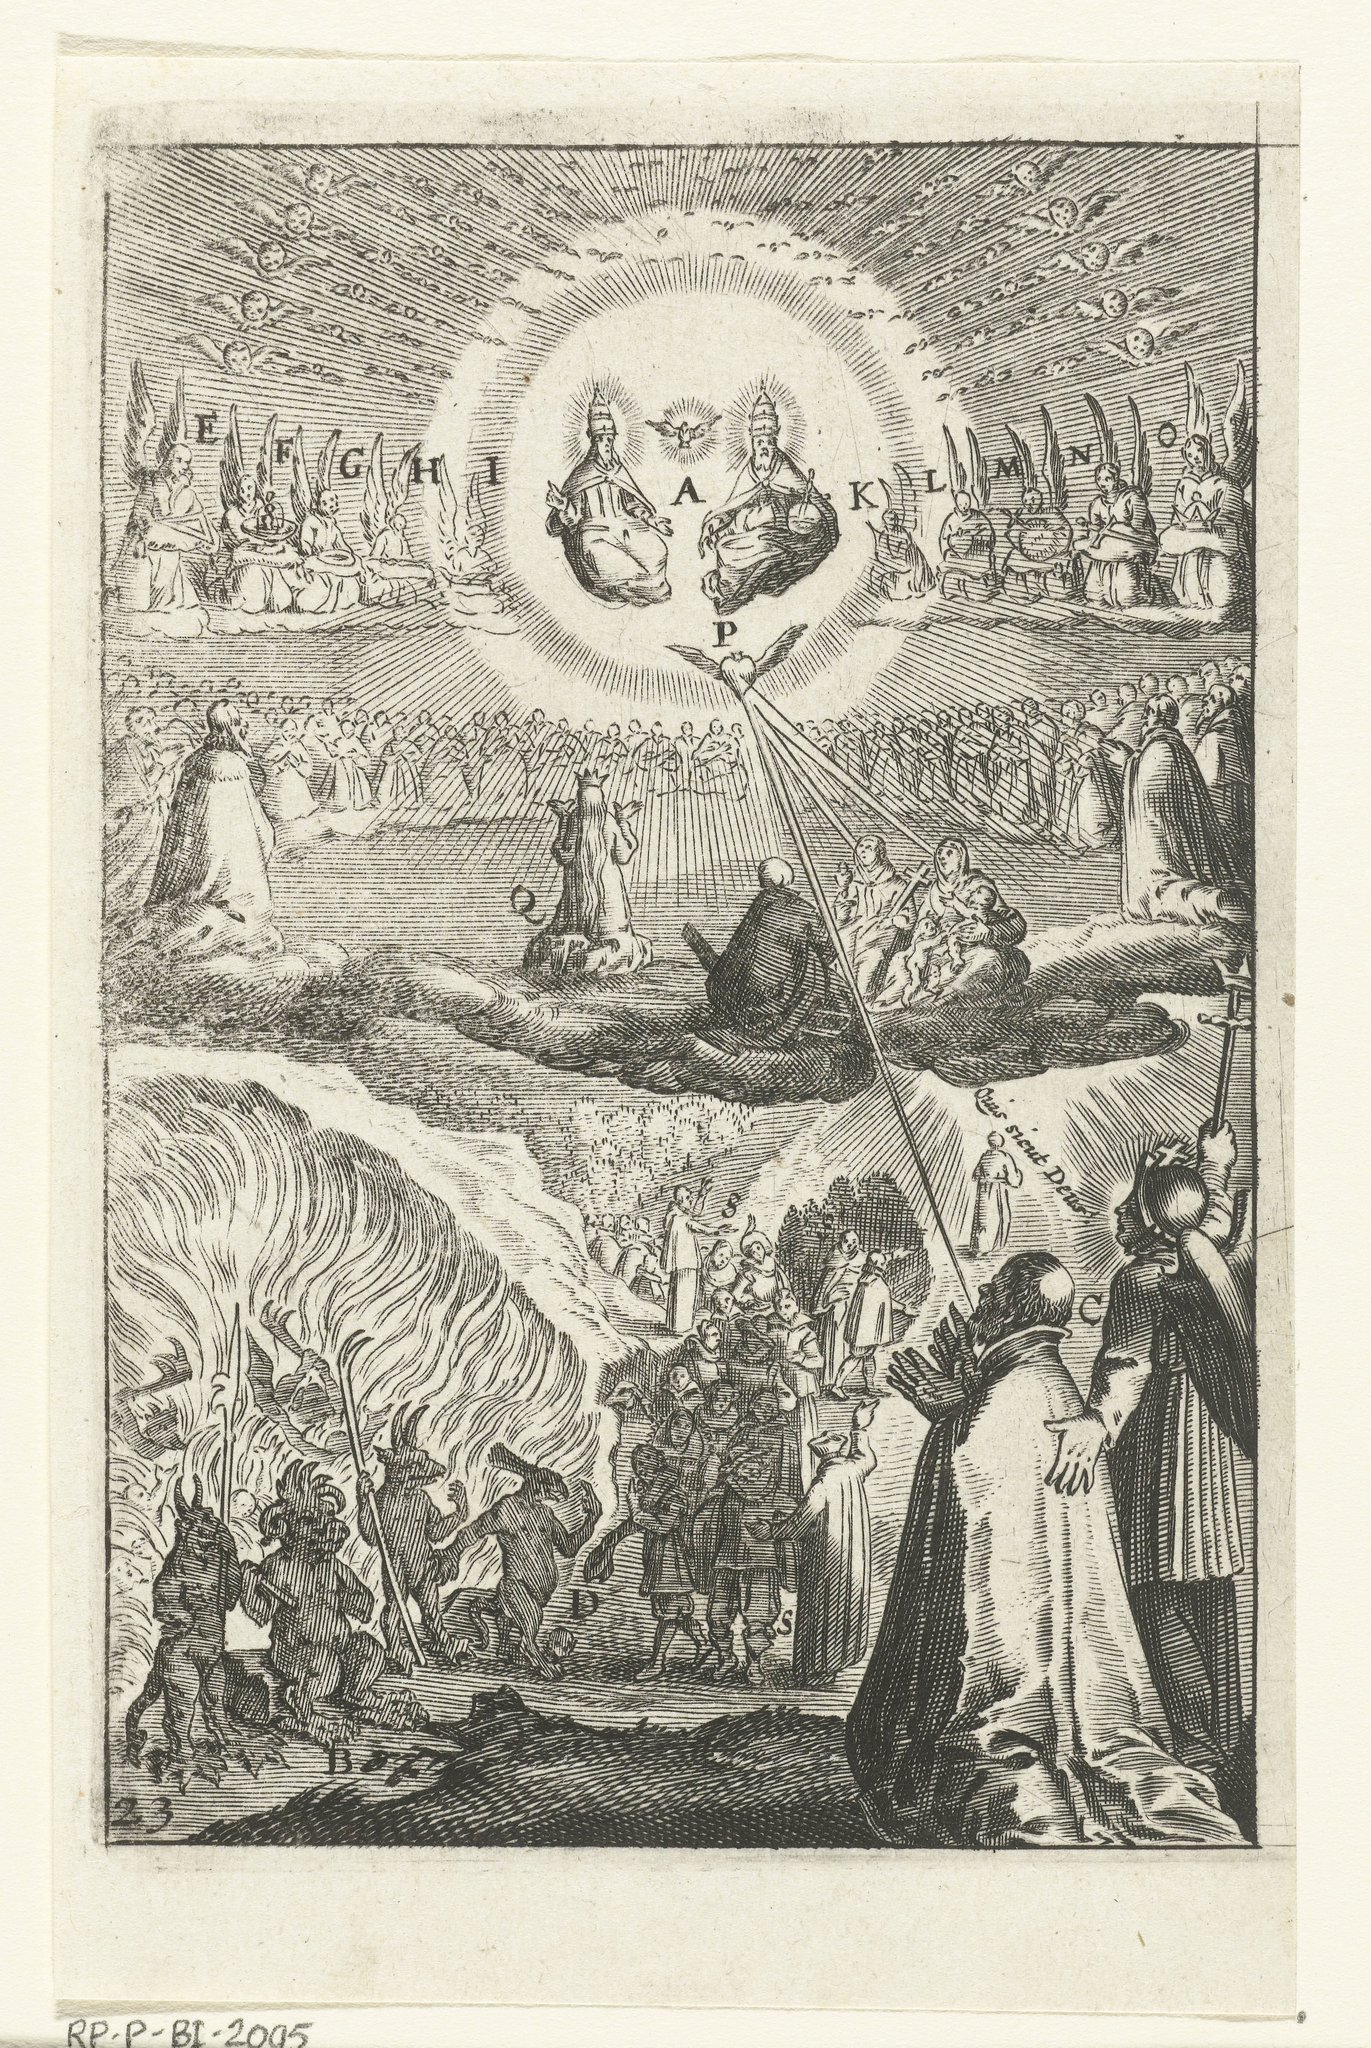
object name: book illustration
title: Embleem met man die moet kiezen of hij God of de duivel zal dienen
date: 1620-1649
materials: paper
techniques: engraving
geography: antwerp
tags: the holy trinity, 'trinitas coelestis'; father, son and holy ghost ~ christian religion, devil(s) and demons, the life of man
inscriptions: collector's mark: Lugt 2228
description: Een engel toont een knielende man twee mogelijkheden. Door te leven in deugd kan hij God dienen. De heilige Drieëenheid is tronend in de hemel met engelenkoren weergegeven. Zijn andere optie is leven in zonde en daarmee de duivel dienen. De duivel als Lucifer troont voor het vagevuur.